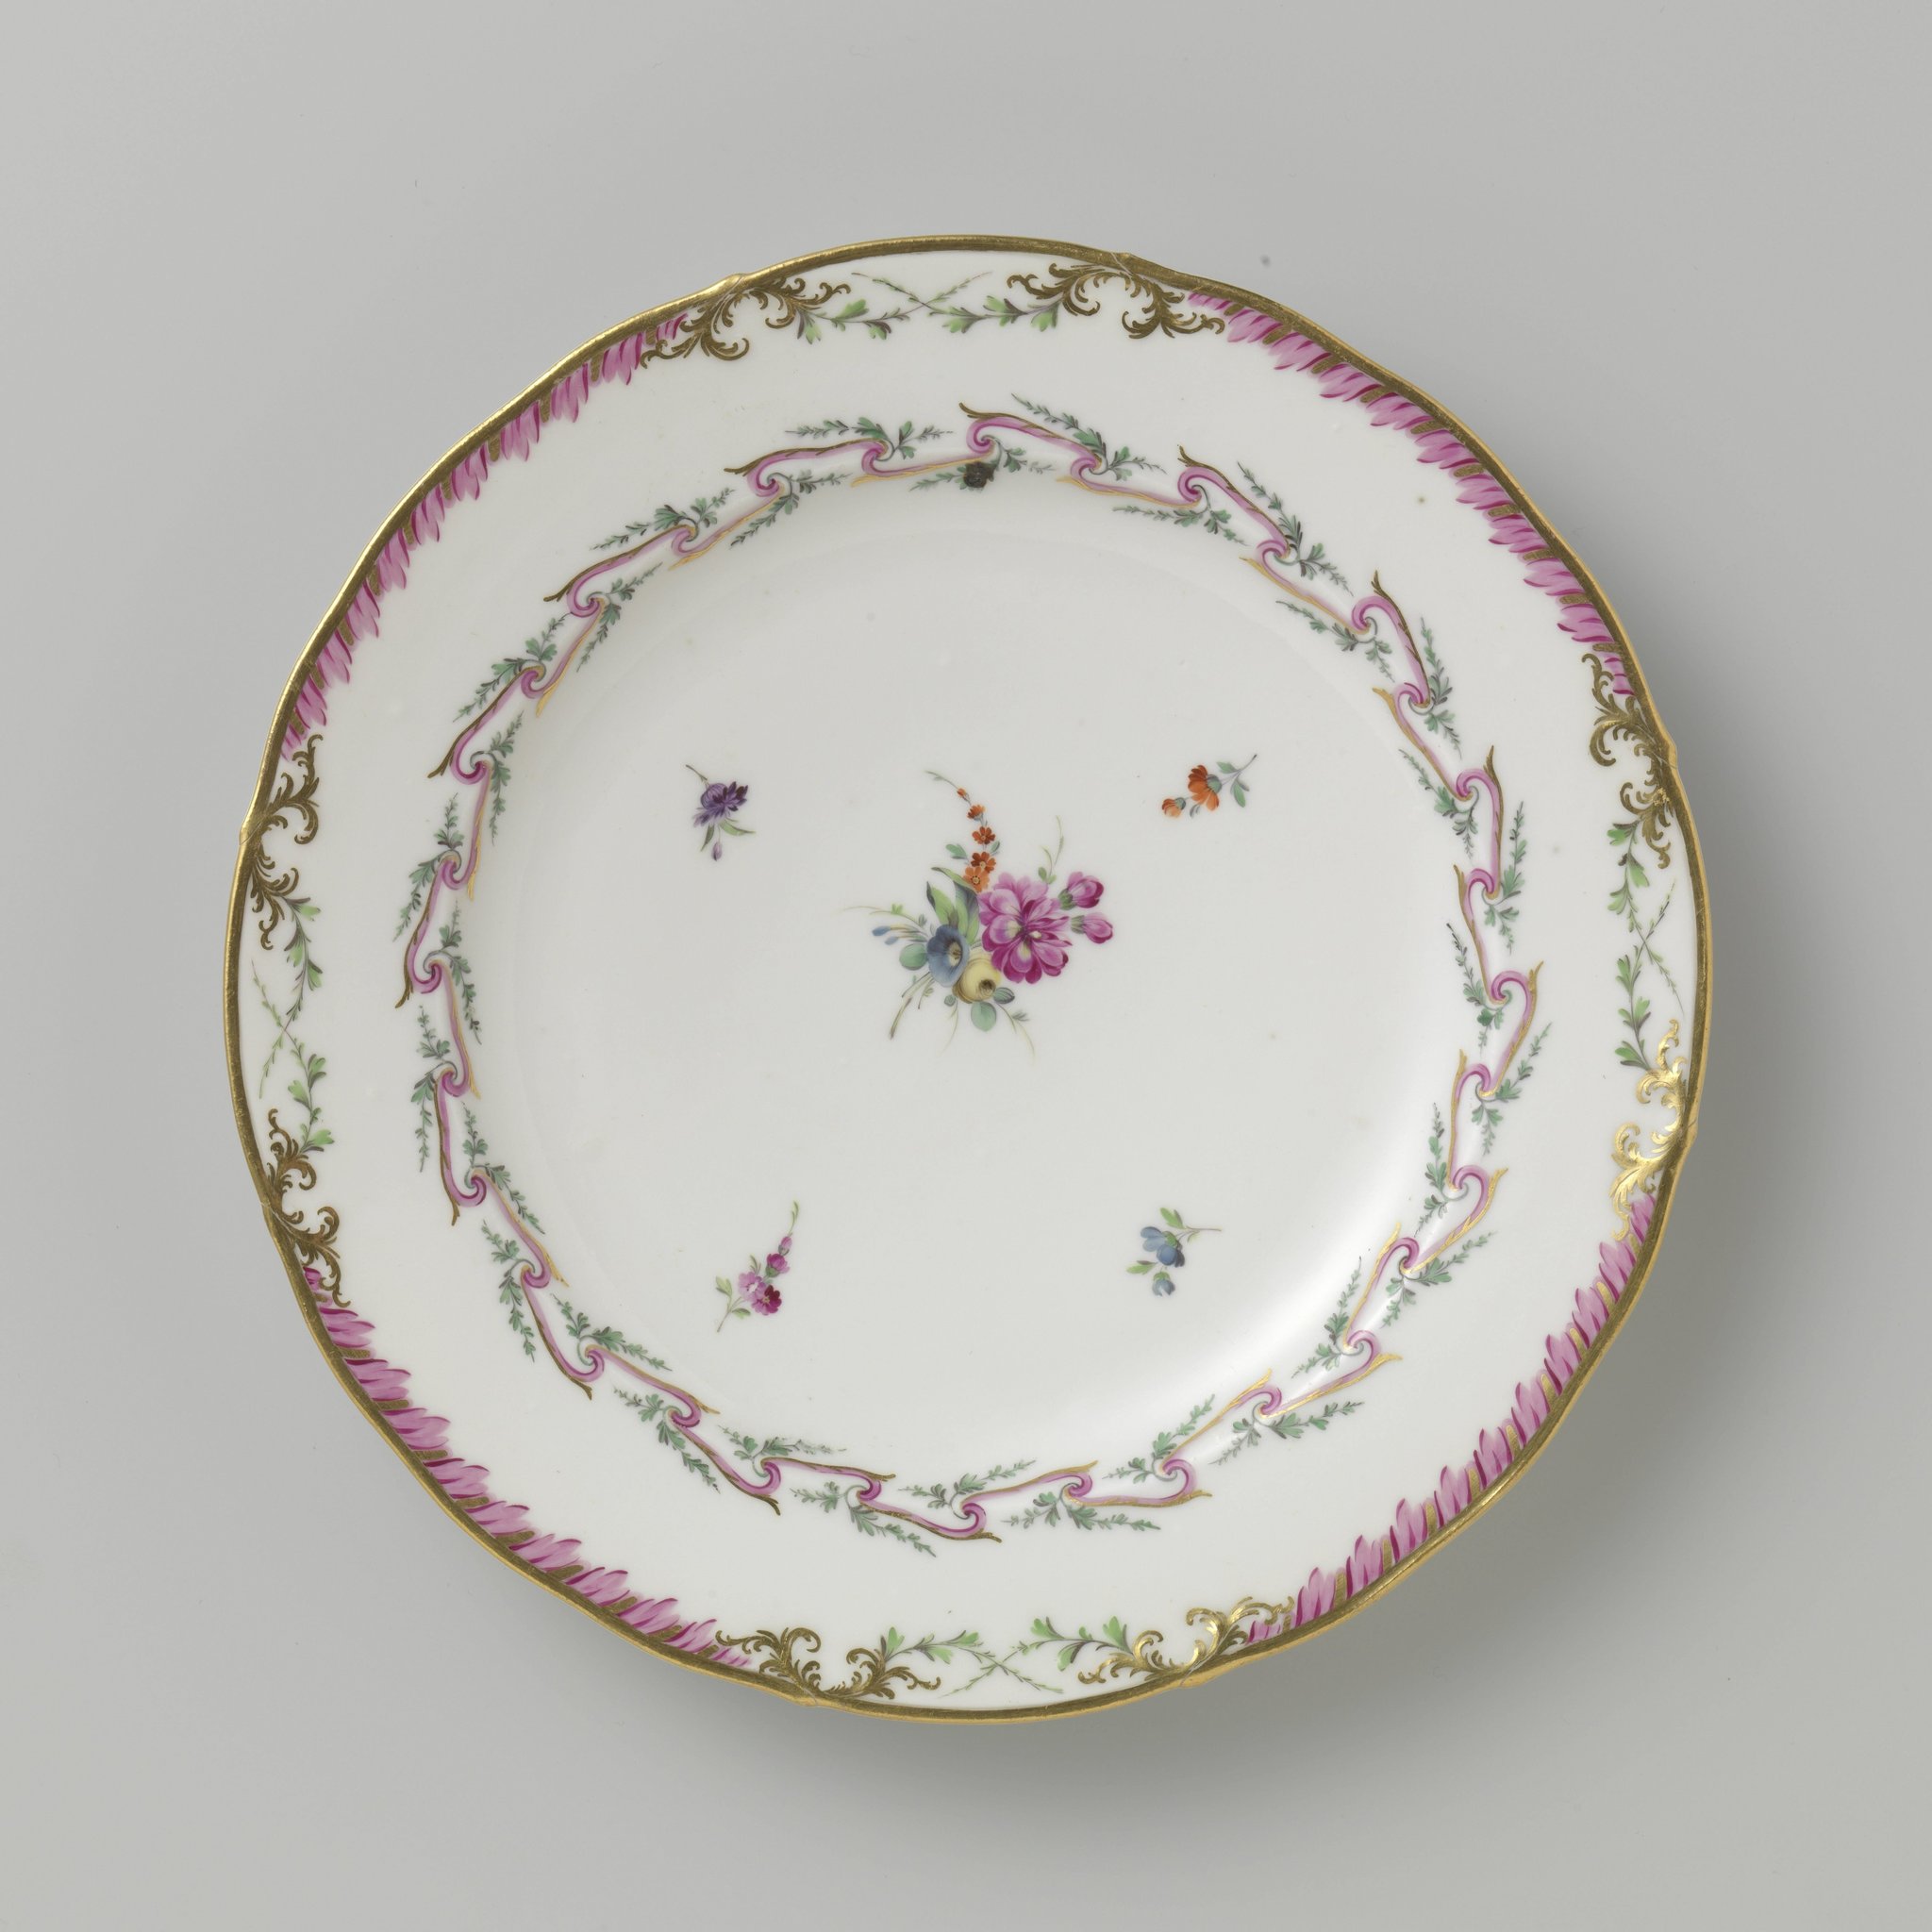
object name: plate dish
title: Bord, plat model, behorend bij een servies met geslingerd lintmotief met bladertakken, bloemboeketten en gestrooide bloemtakken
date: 1780-1820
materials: porcelain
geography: amsterdam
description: Bord, plat model, behorend bij een servies van porselein met geslingerd lintmotief in paars en goud met groene bladertakken, bloemboeketten en gestrooide bloemtakken. Randen lichtgegolfd met decoratie in goud met paars bladmotief waartussen groen gekruist bladmotief. Gemerkt: M.O.L. of AMSTEL.